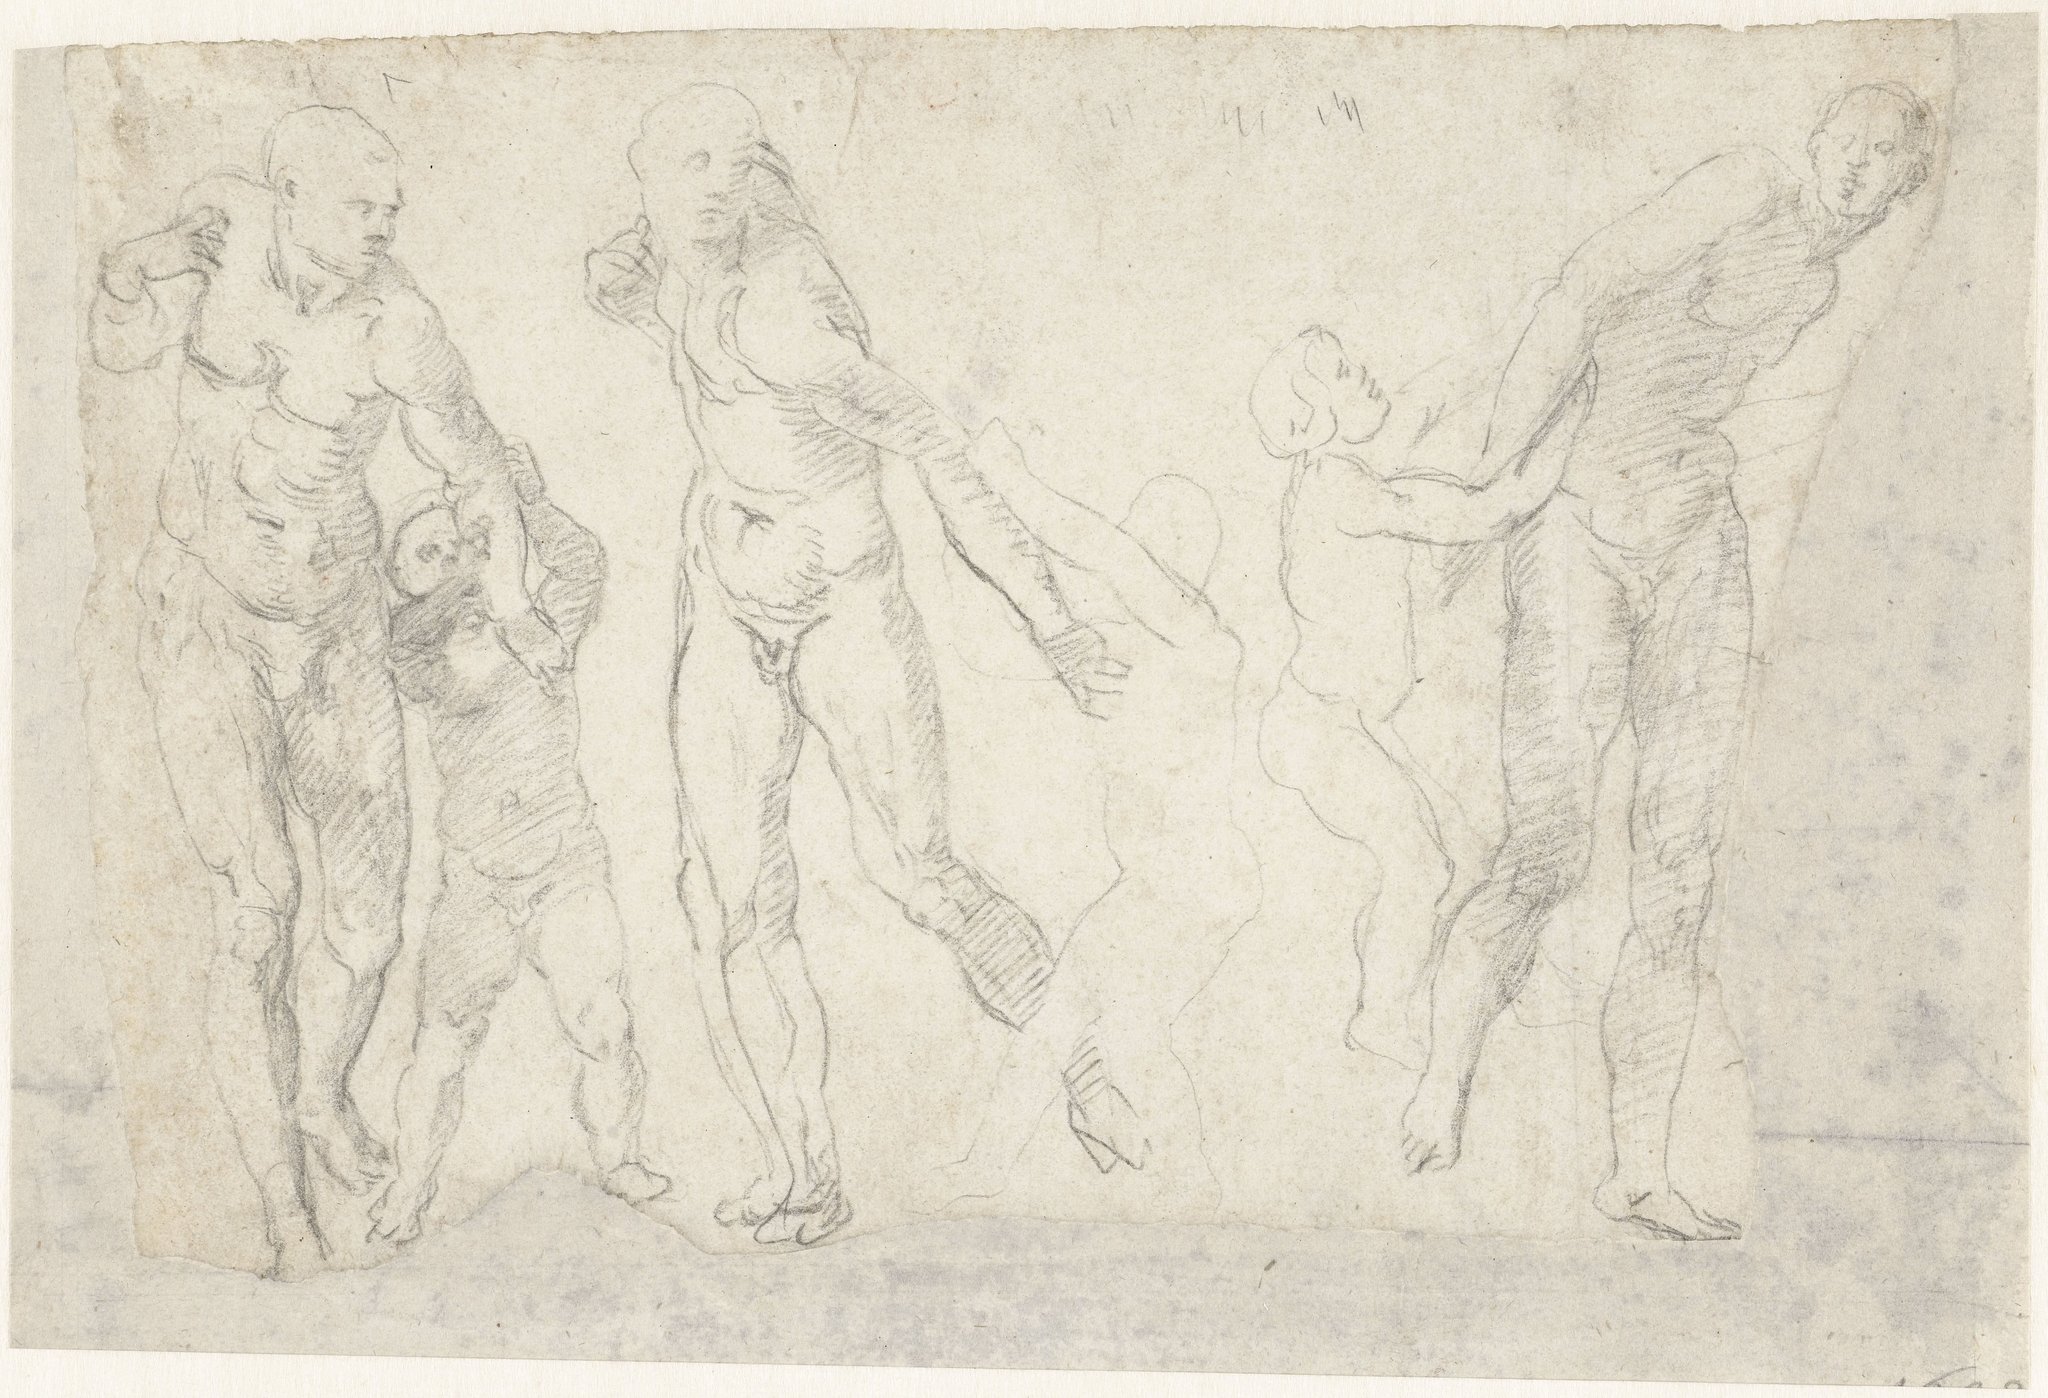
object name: drawing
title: Drie studies van een man, die door een kind aan de arm wordt getrokken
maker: daniele da volterra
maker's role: draughtsman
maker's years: 1509-1566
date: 1519-1566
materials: chalk, paper